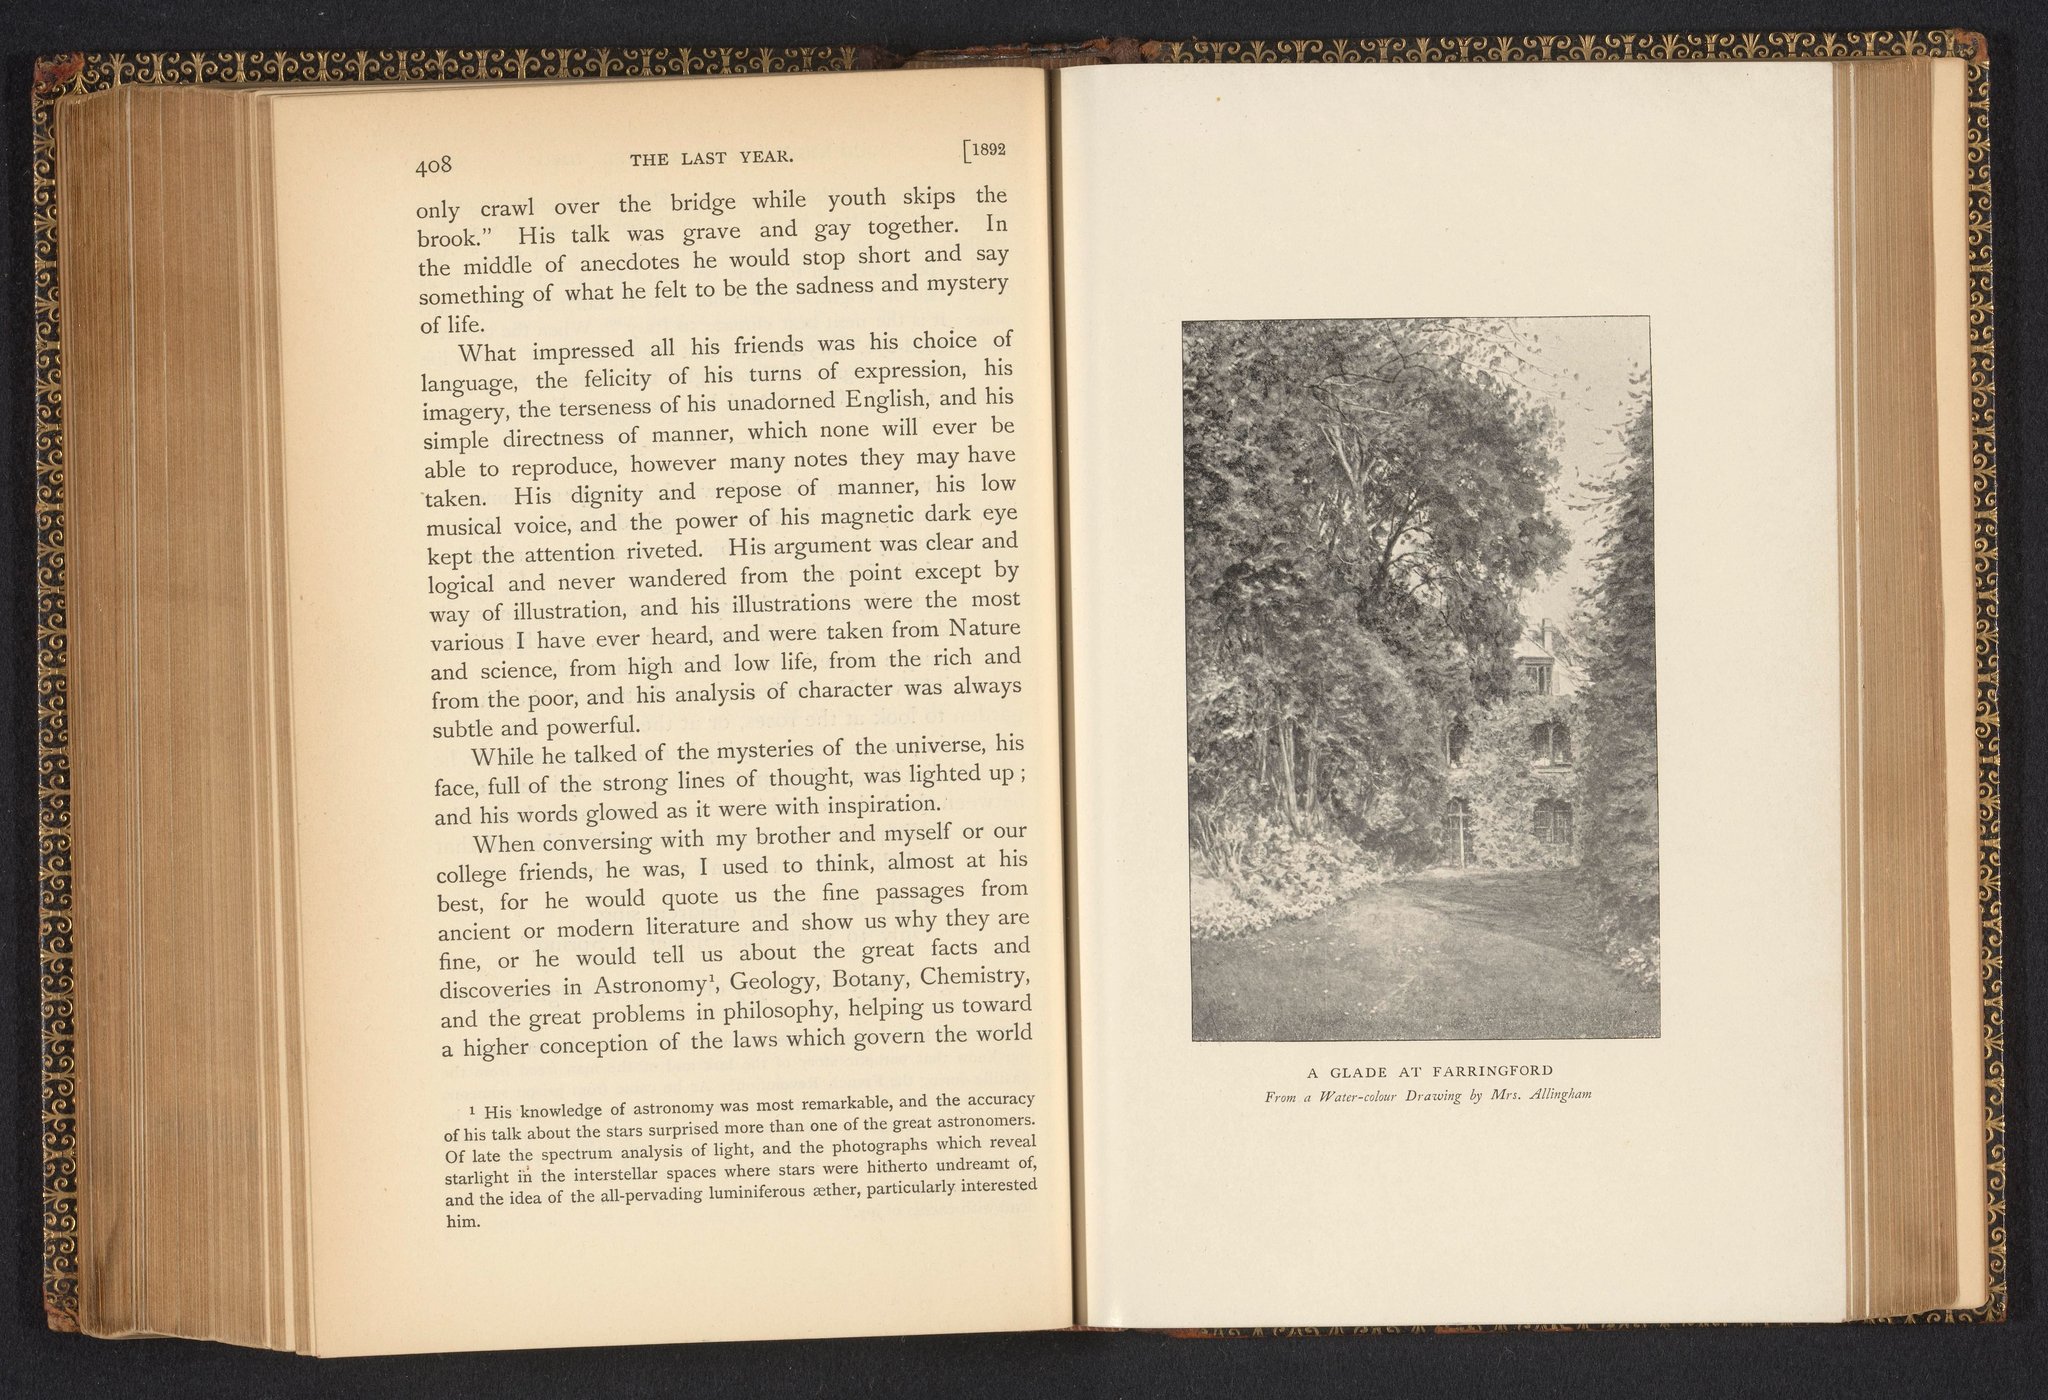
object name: page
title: A glade at Farringford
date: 1887-1897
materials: paper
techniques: autotype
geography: isle of wight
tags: façade (of house or building), country-house